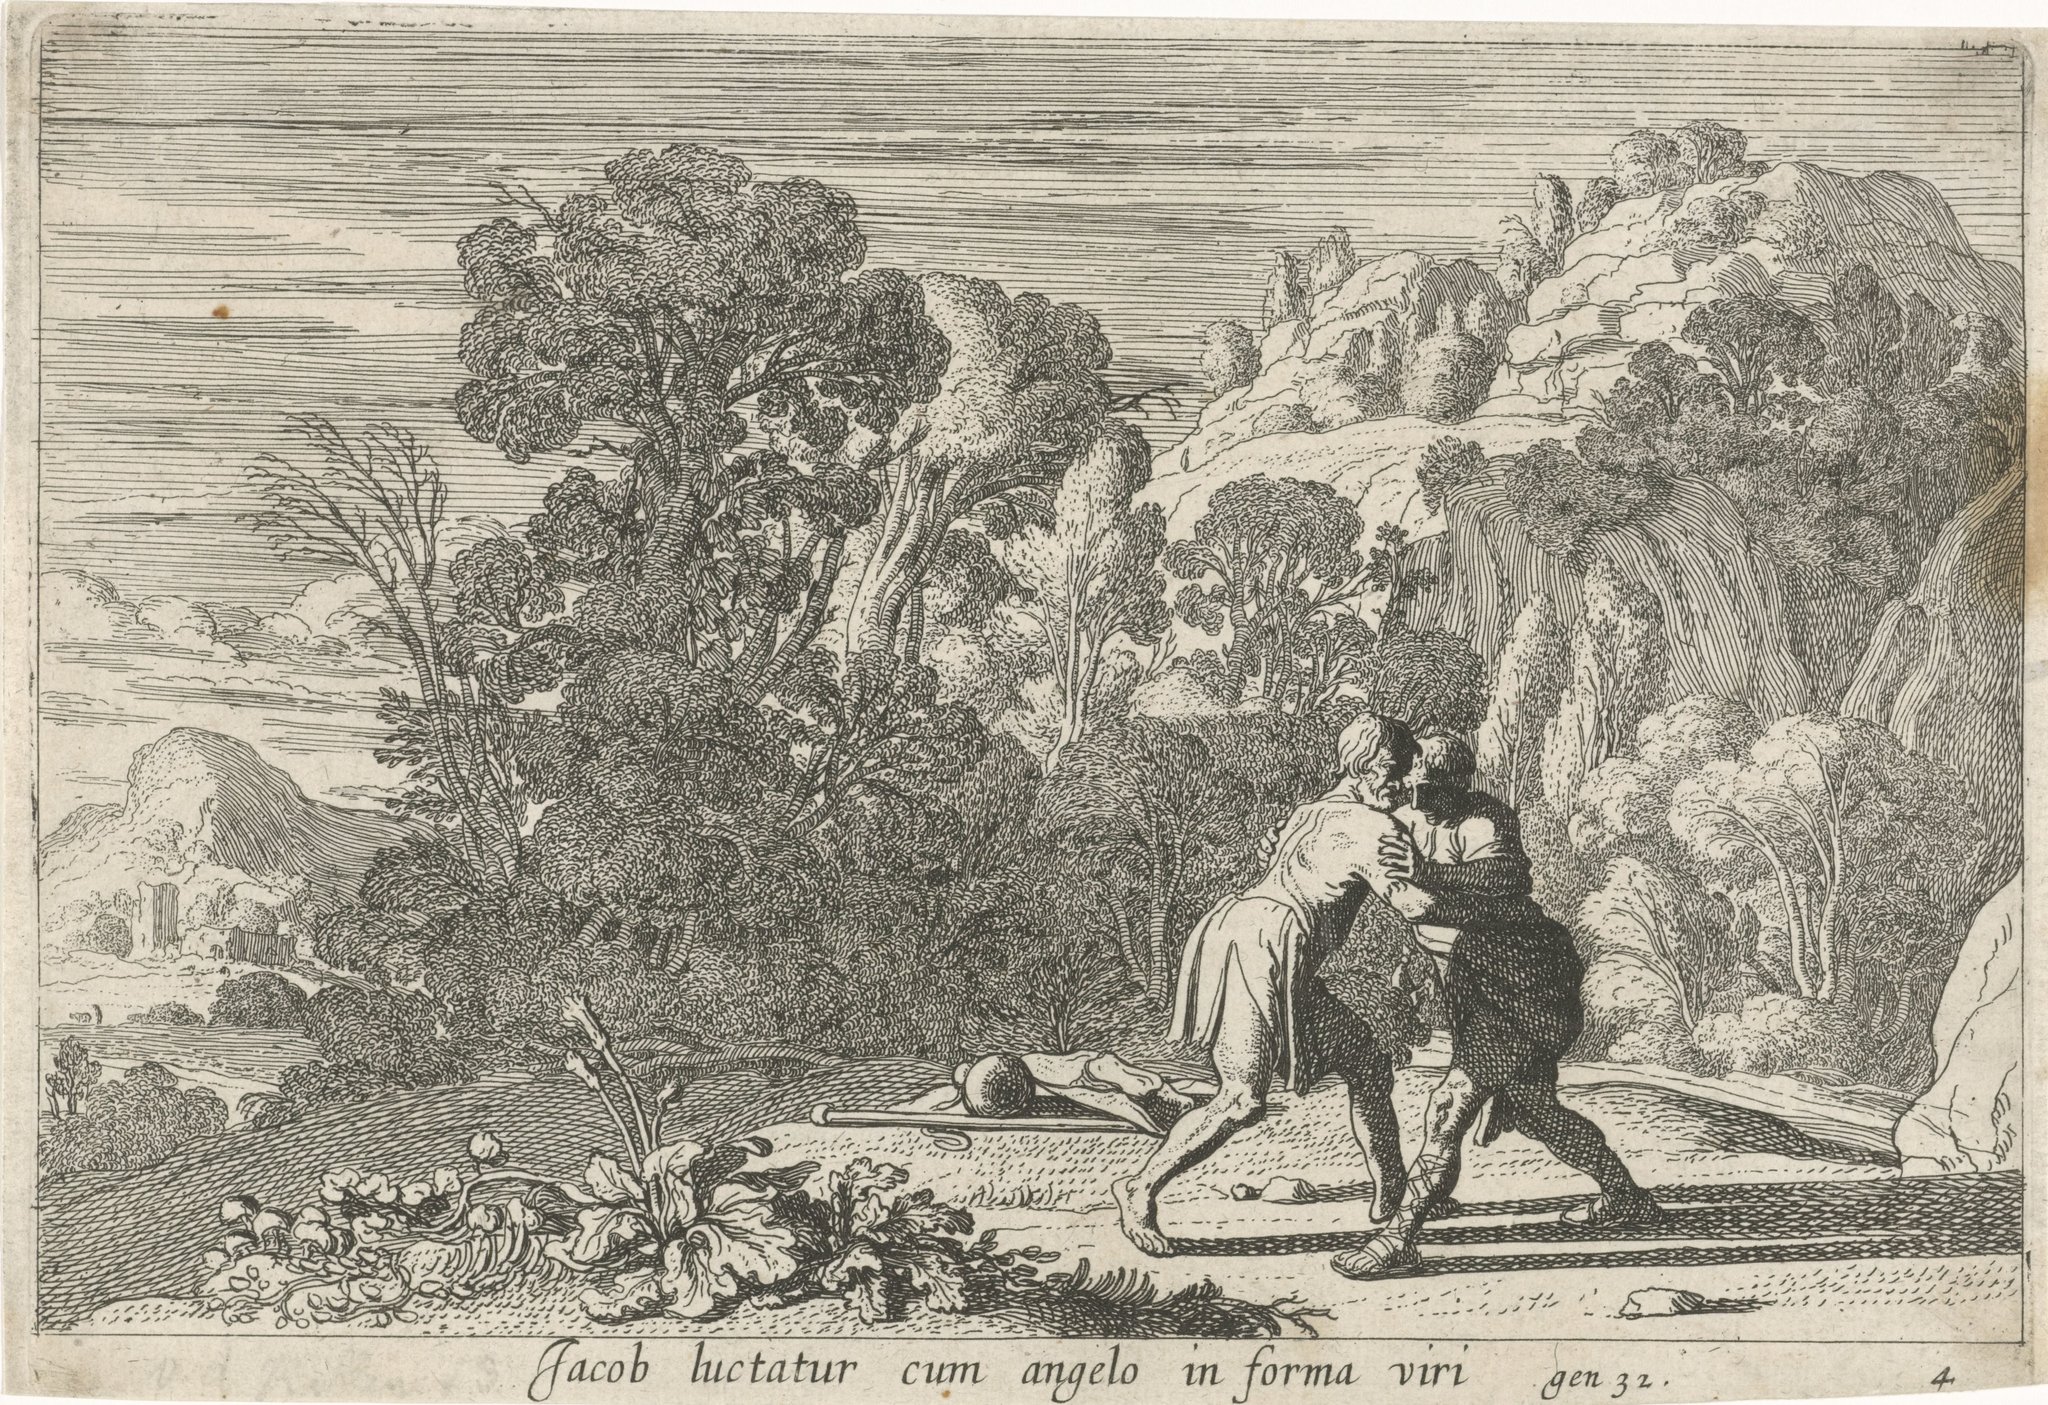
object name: print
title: Jakob worstelt met de engel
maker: claes moeyaert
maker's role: draughtsman, painter, print maker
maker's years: 1592-1655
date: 1612-1655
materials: paper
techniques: etching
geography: amsterdam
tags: jacob wrestles with the angel (or man) till daybreak; jacob's thigh is put out of joint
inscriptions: collector's mark: Lugt 2228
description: Jakob worstelt met de engel bij de rivier de Jabbok. Op de grond liggen Jakobs kruik en staf. Onderaan in de marge een verwijzing in het Latijn naar de Bijbeltekst in Gen. 32.